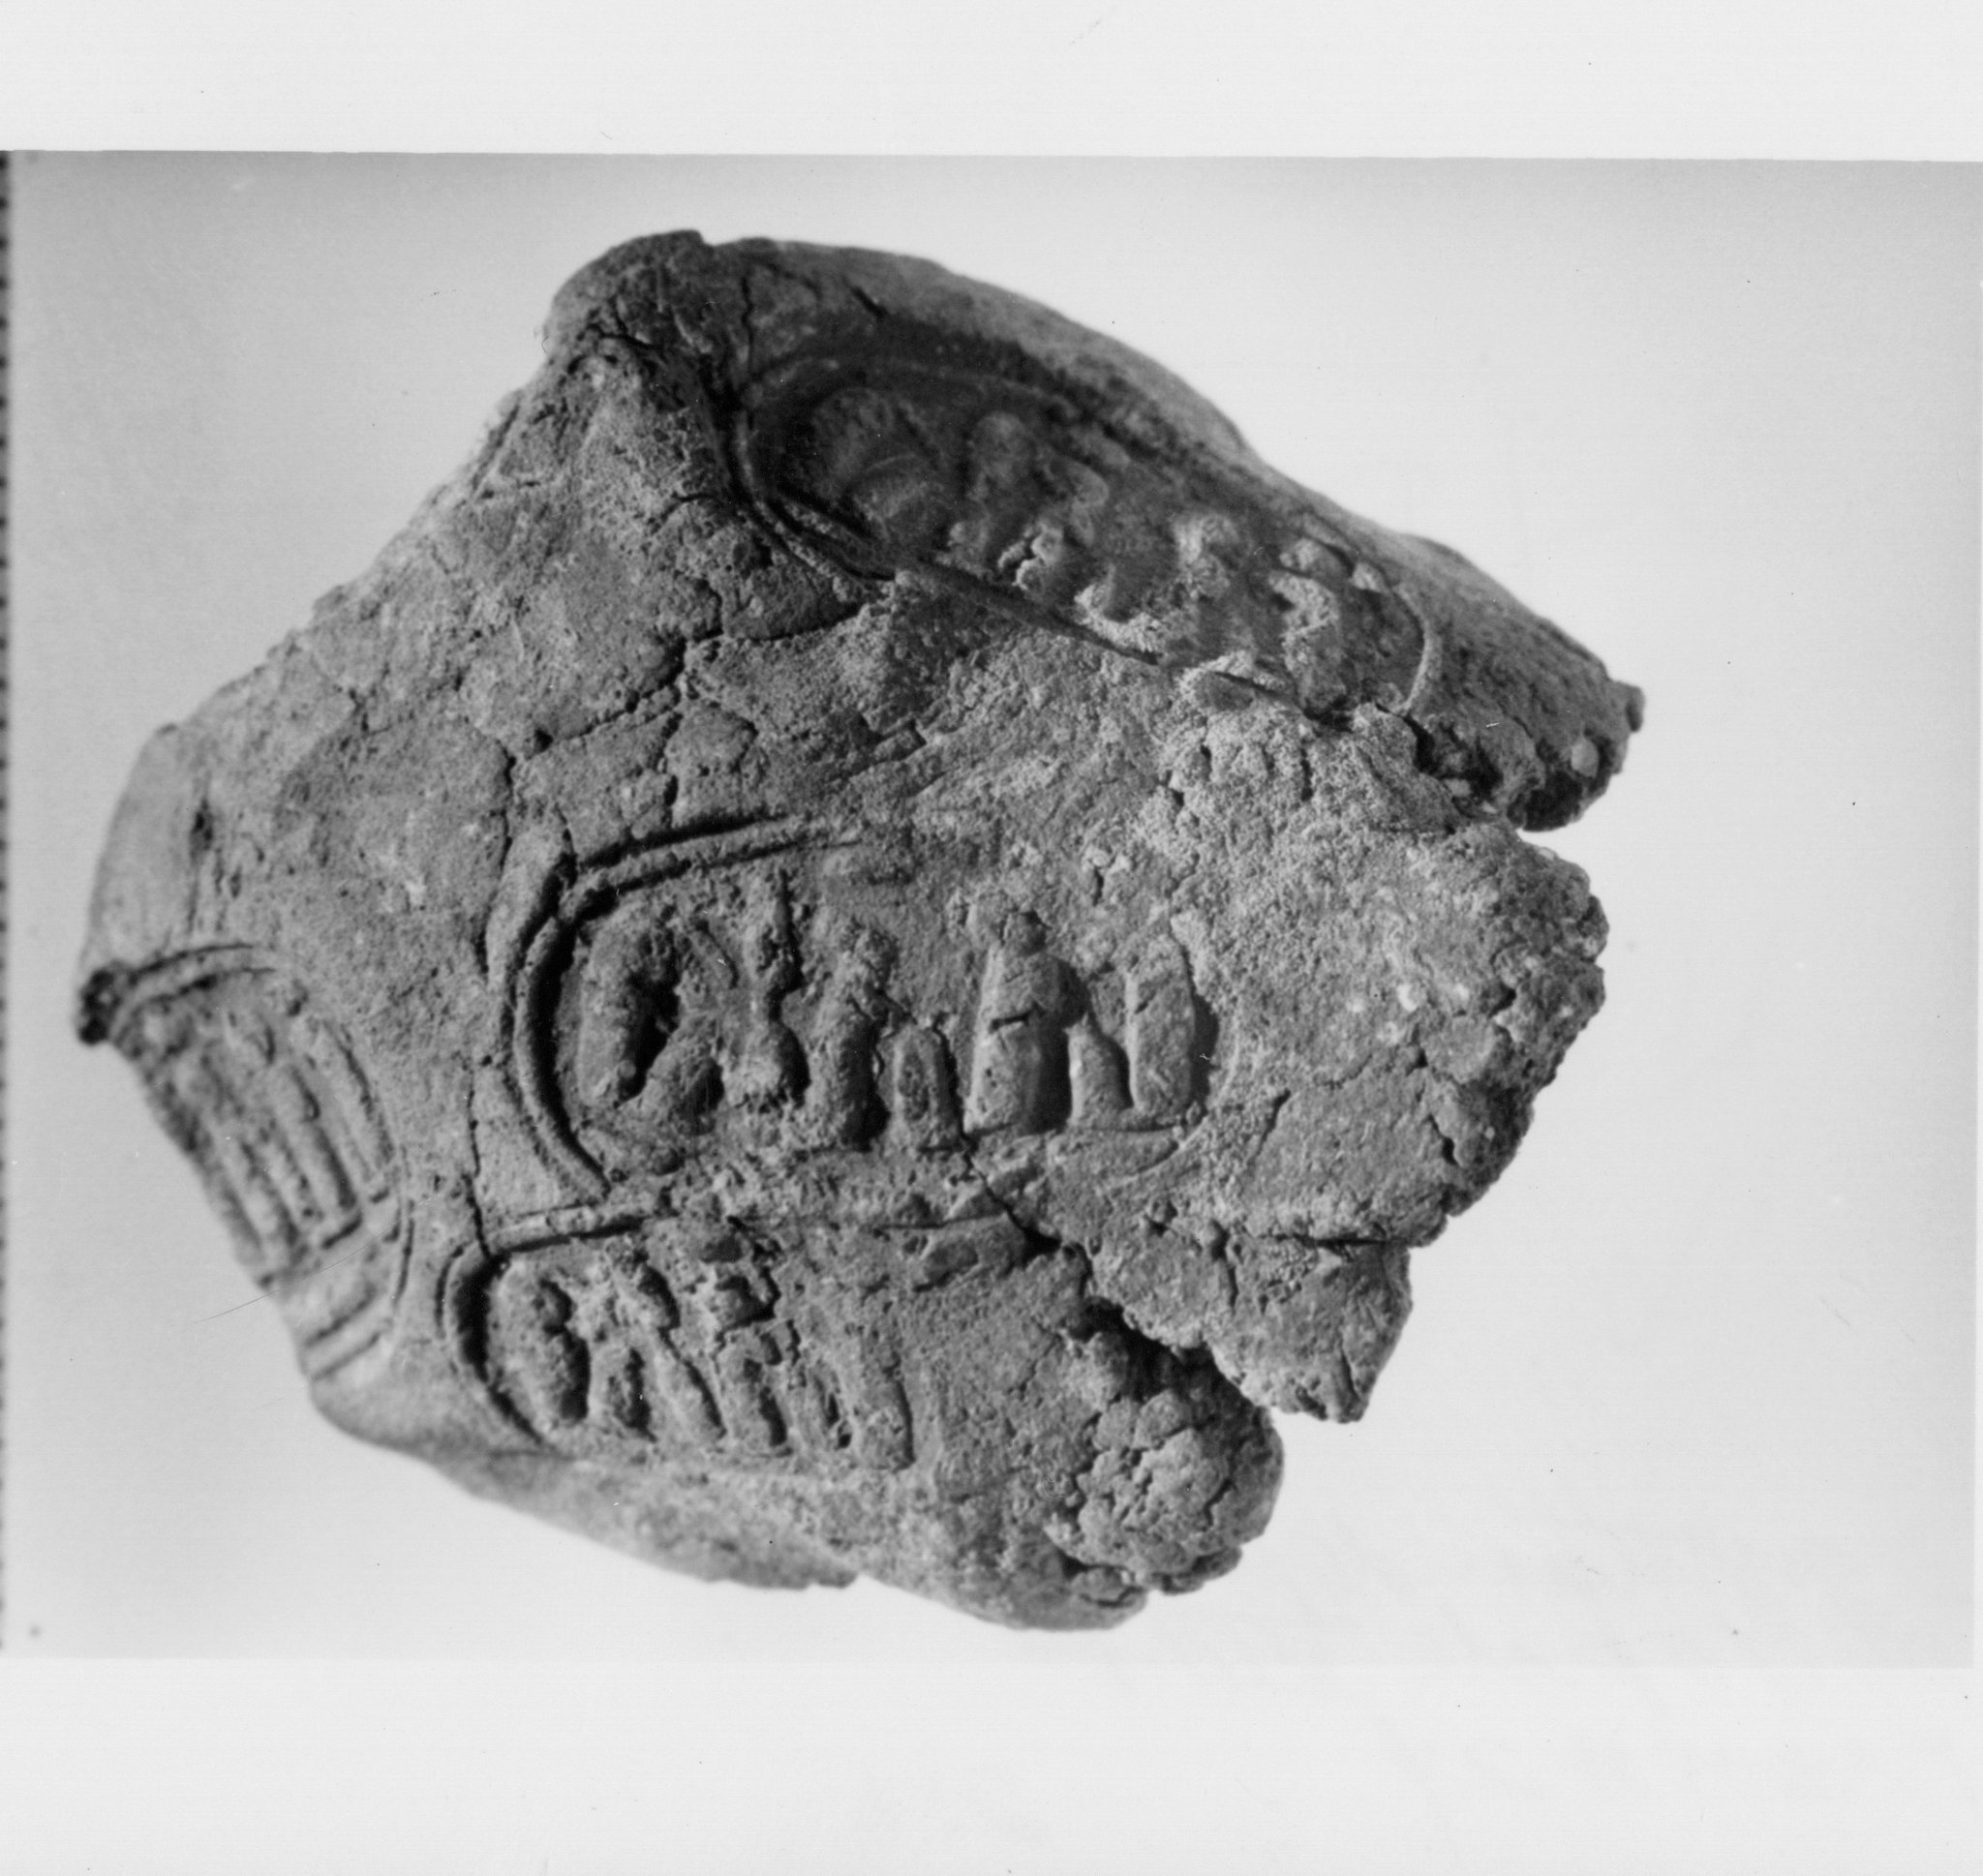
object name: sealing, nebmaatre, amenhotep iii, thoth, ptah, sakhmet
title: Document Sealing With the Throne Name of Amenhotep III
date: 1390-1352 BCE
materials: mud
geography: egypt